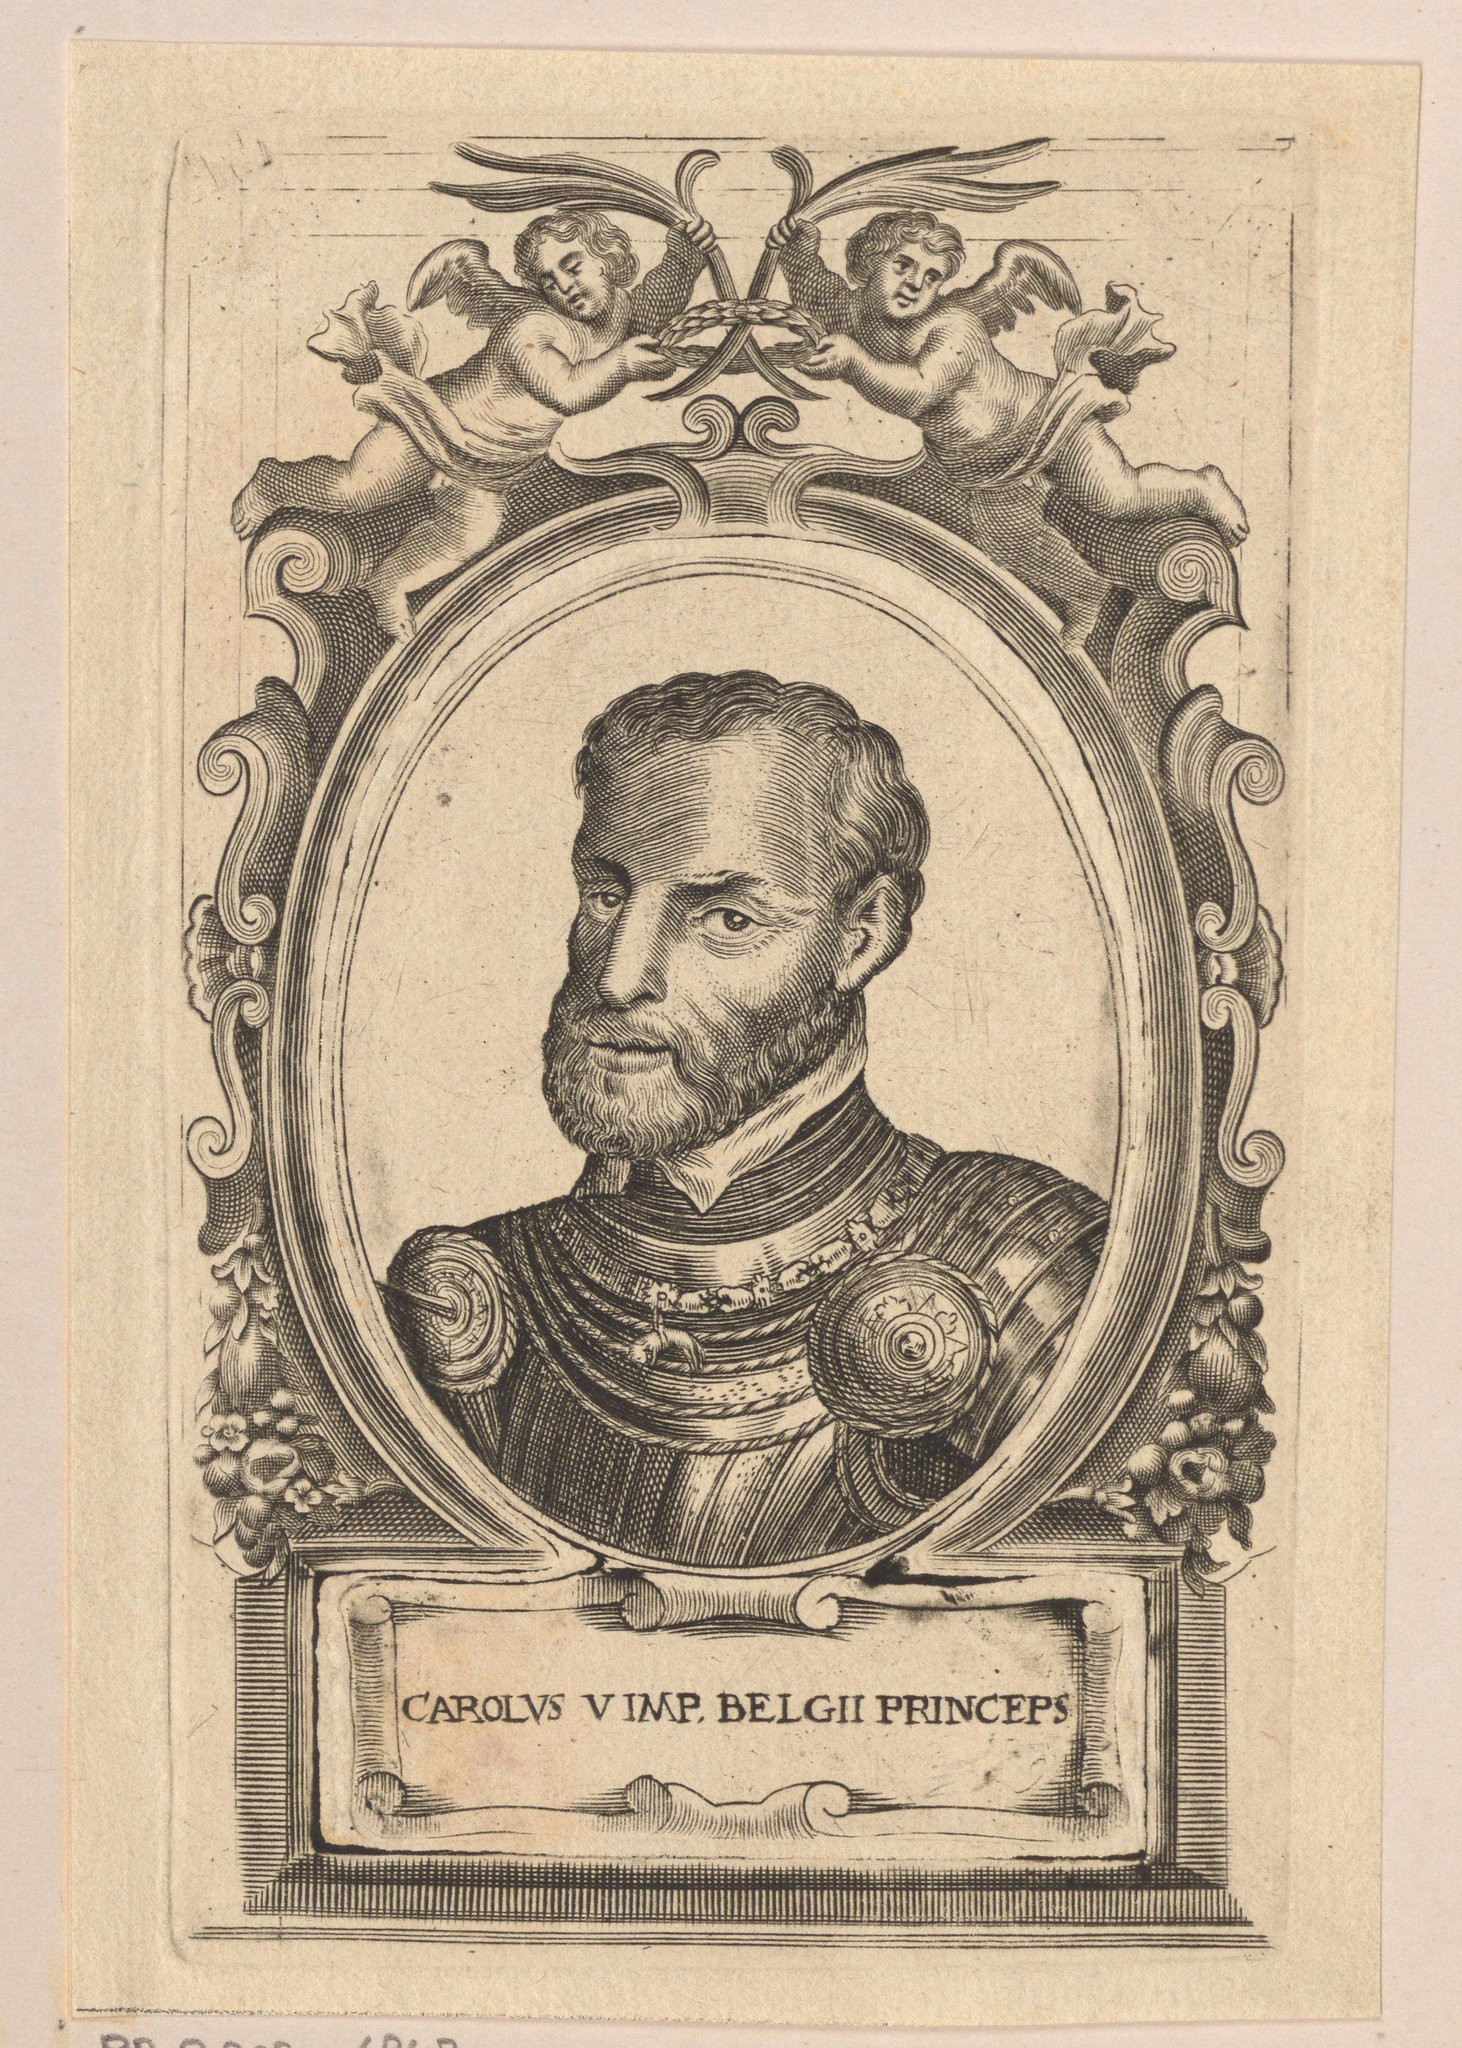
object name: print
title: Portret van keizer Karel V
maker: Anonymous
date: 1650-1749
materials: paper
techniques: engraving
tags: ghent, charles v (holy roman emperor and king of spain), historical persons, knighthood order of the golden fleece, cupids: 'amores', 'amoretti', 'putti', king